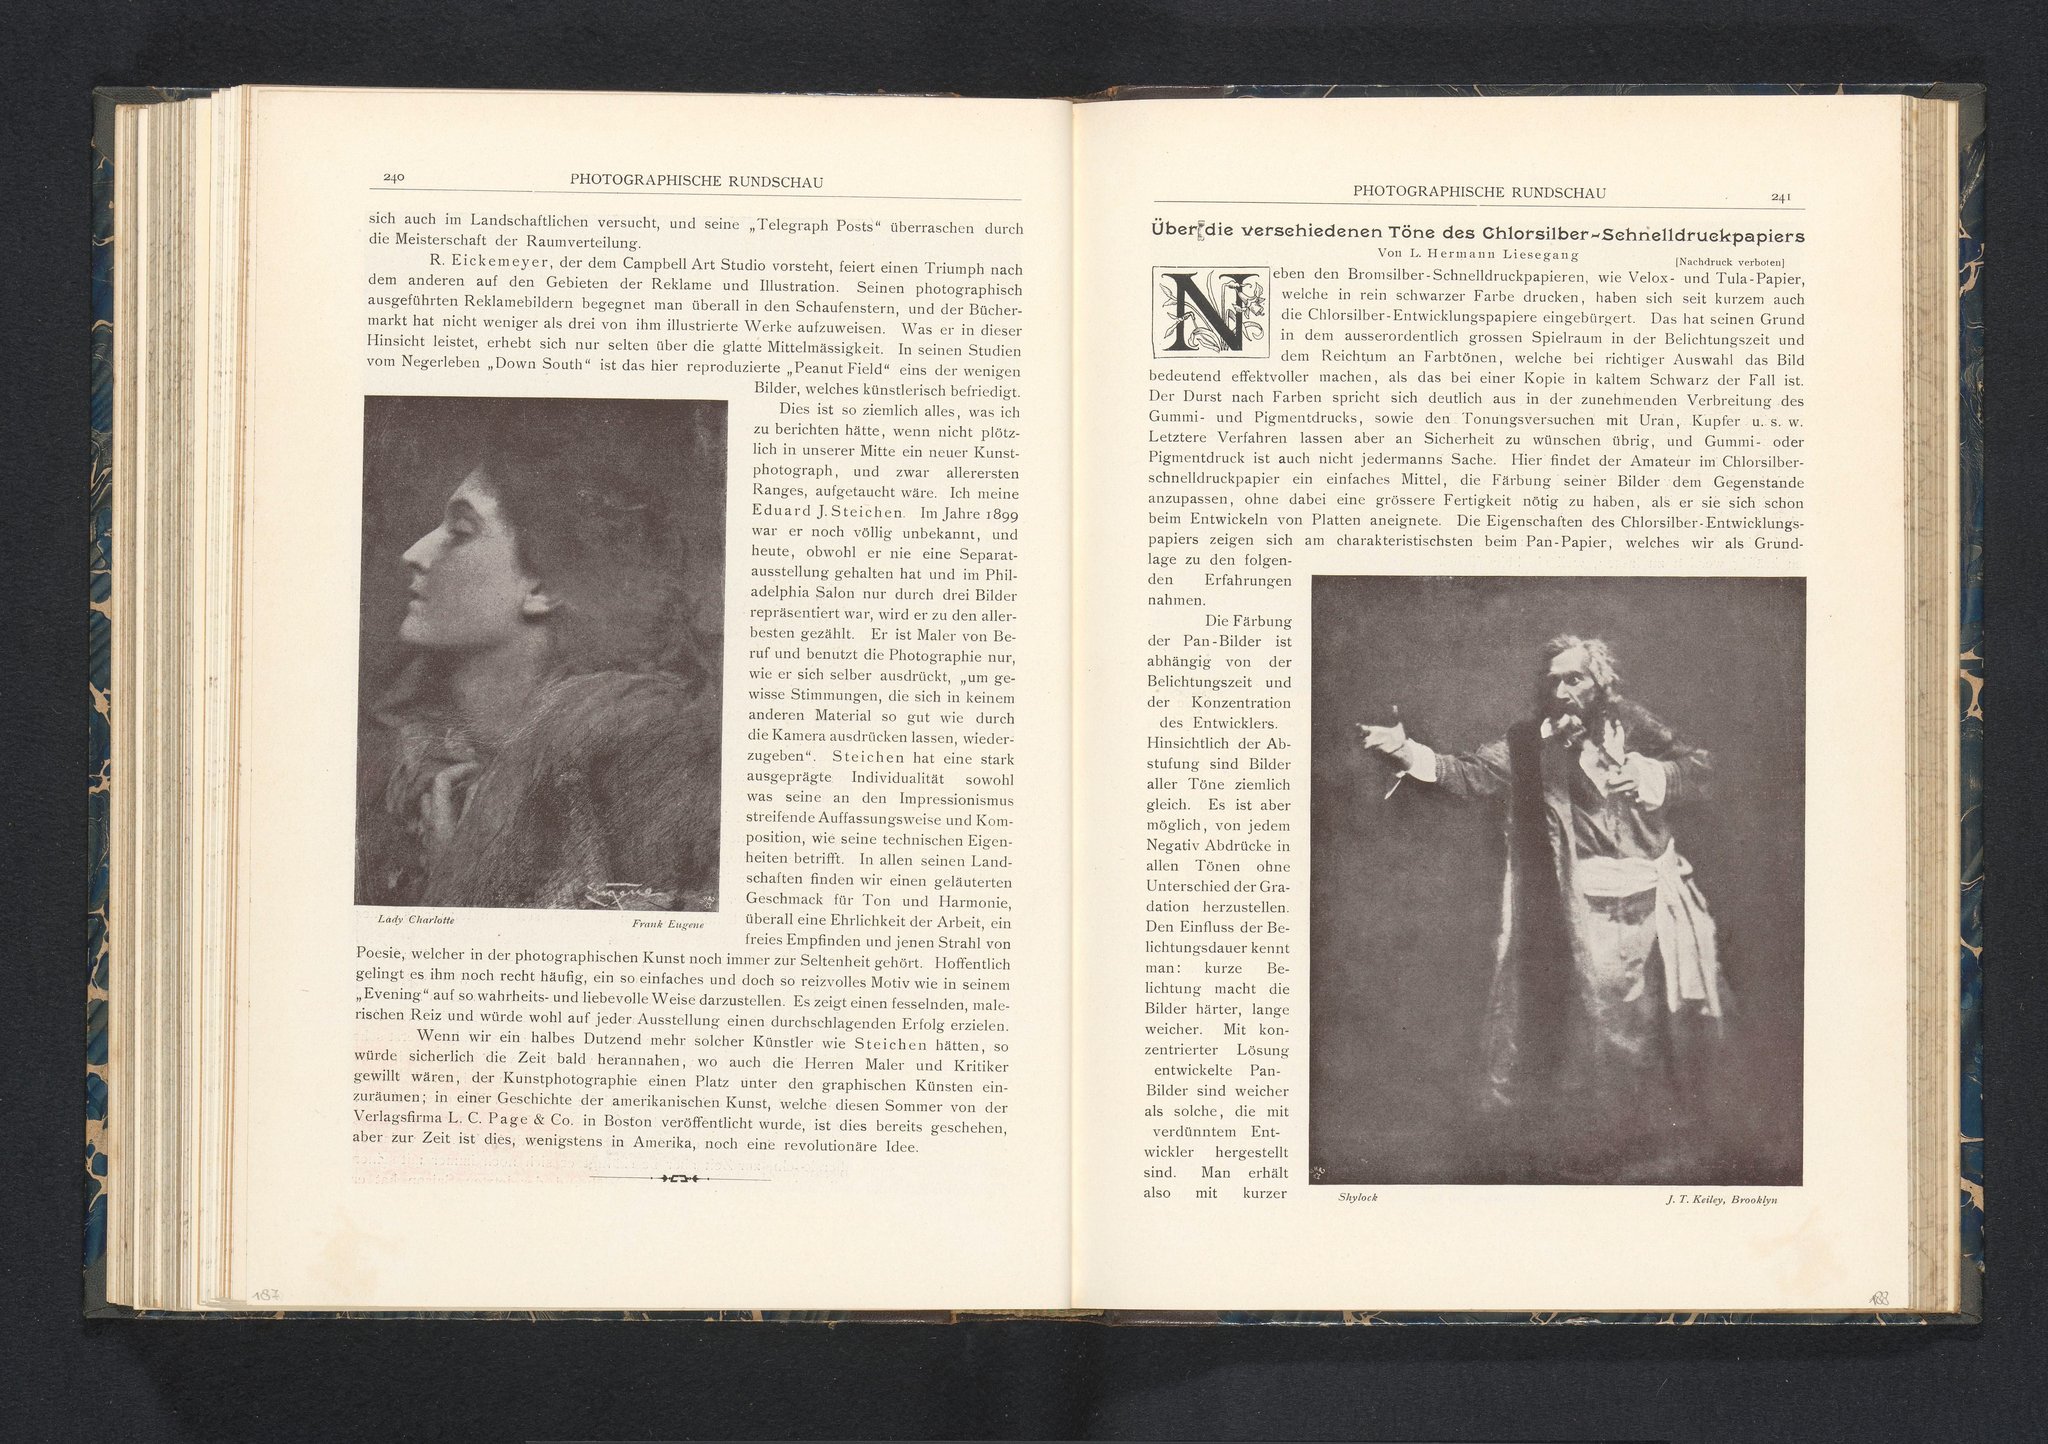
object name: photomechanical print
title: Portret van een onbekende acteur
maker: joseph turner keiley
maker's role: auteur, fotograaf, kunsthistoricus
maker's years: 1869-1914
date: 1896-1901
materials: paper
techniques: autotype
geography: berlin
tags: actor (on the stage)